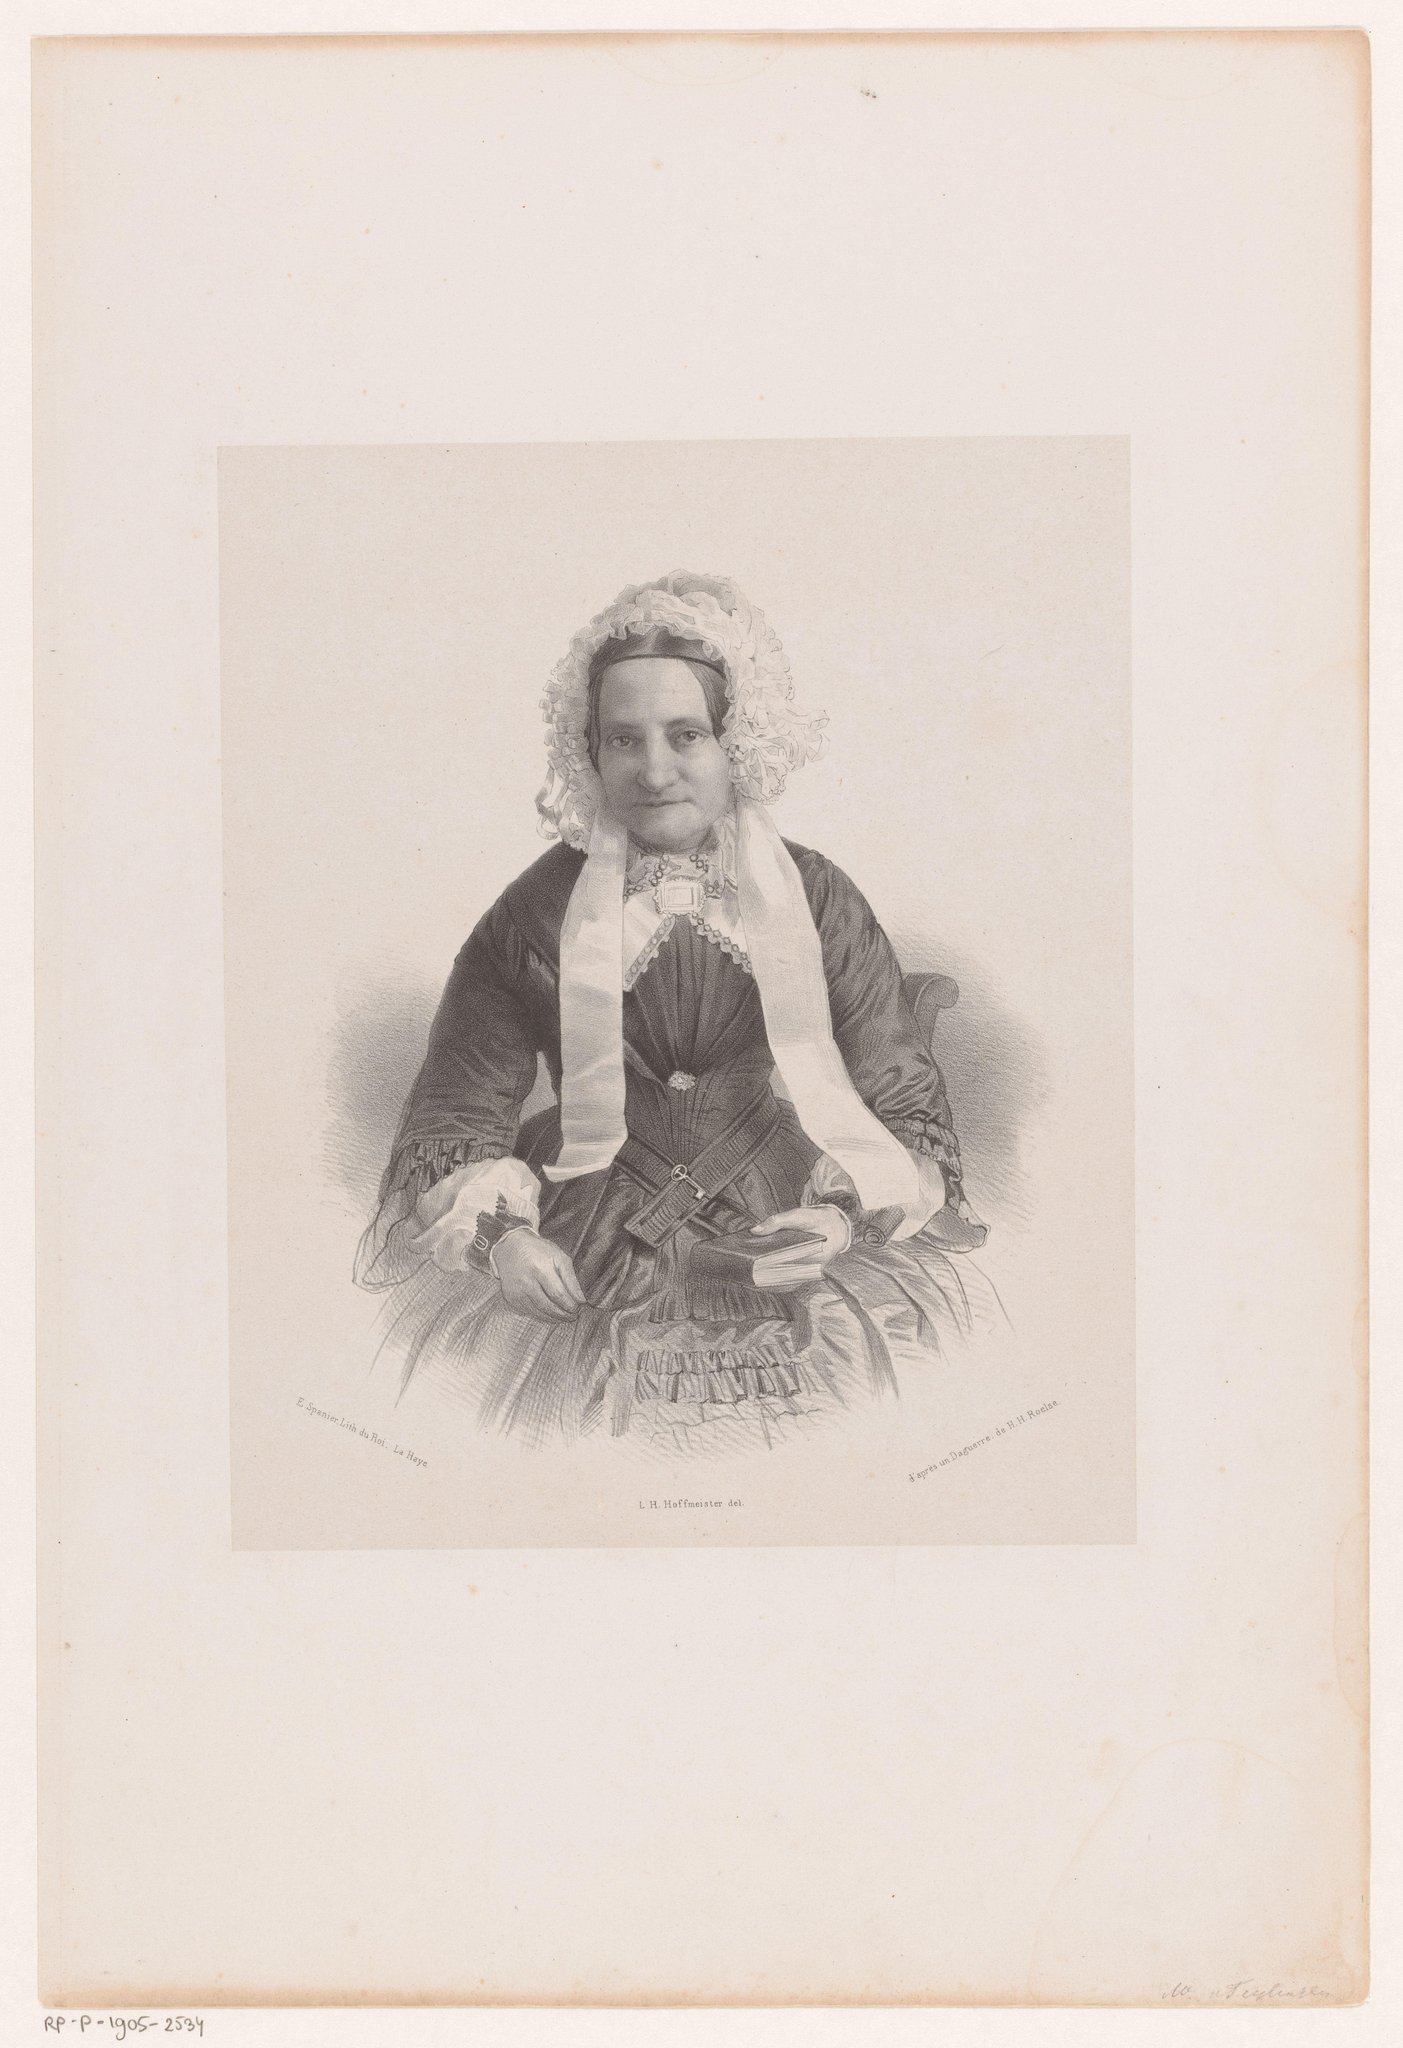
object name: print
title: Portret van een onbekende vrouw, mogelijk mevrouw Van Teylingen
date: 1851-1883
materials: paper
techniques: lithograph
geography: middelburg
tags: historical persons - bb - woman (+ (full) bust portrait), book, head-gear: cap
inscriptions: collector's mark: Lugt 2228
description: De geportretteerde draagt een muts met lange linten. In haar linkerhand heeft zij een boek.